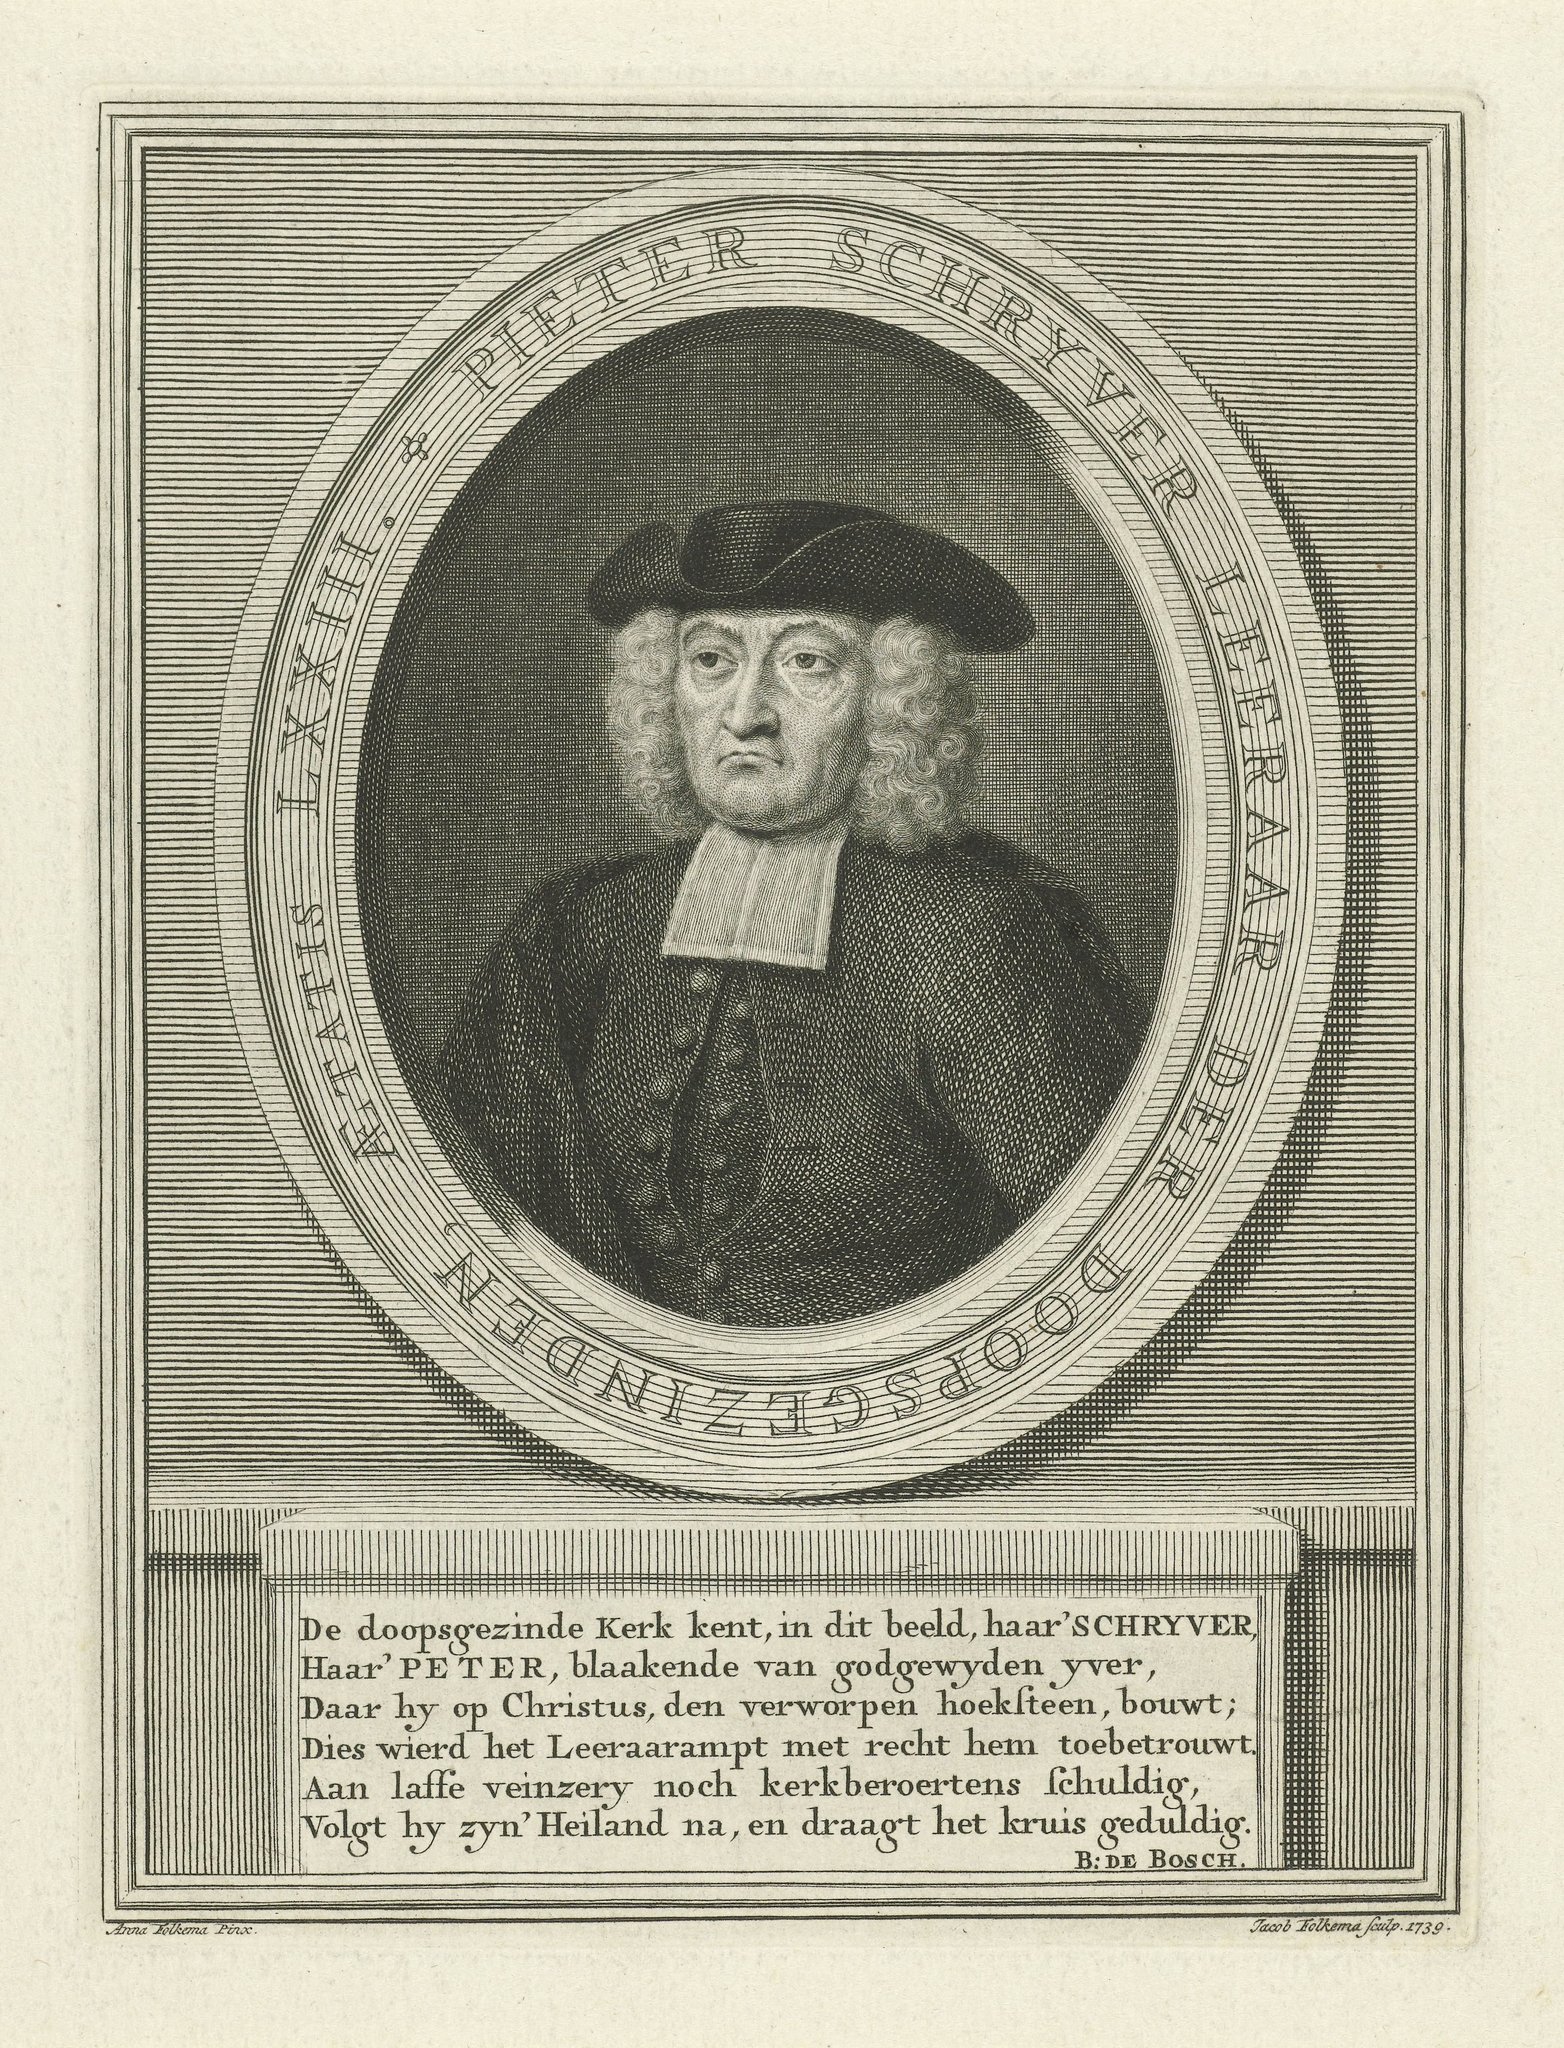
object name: print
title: Portret van Pieter Schrijver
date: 1739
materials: paper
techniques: engraving, etching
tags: predikant, pieter schrijver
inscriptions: collector's mark: Lugt 2228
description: Portretbuste in ovaal naar links van predikant Pieter Schrijver, met hoed. Het portret wordt omgeven door een randschrift, op de sokkel staat een zesregelig vers in het Nederlands.